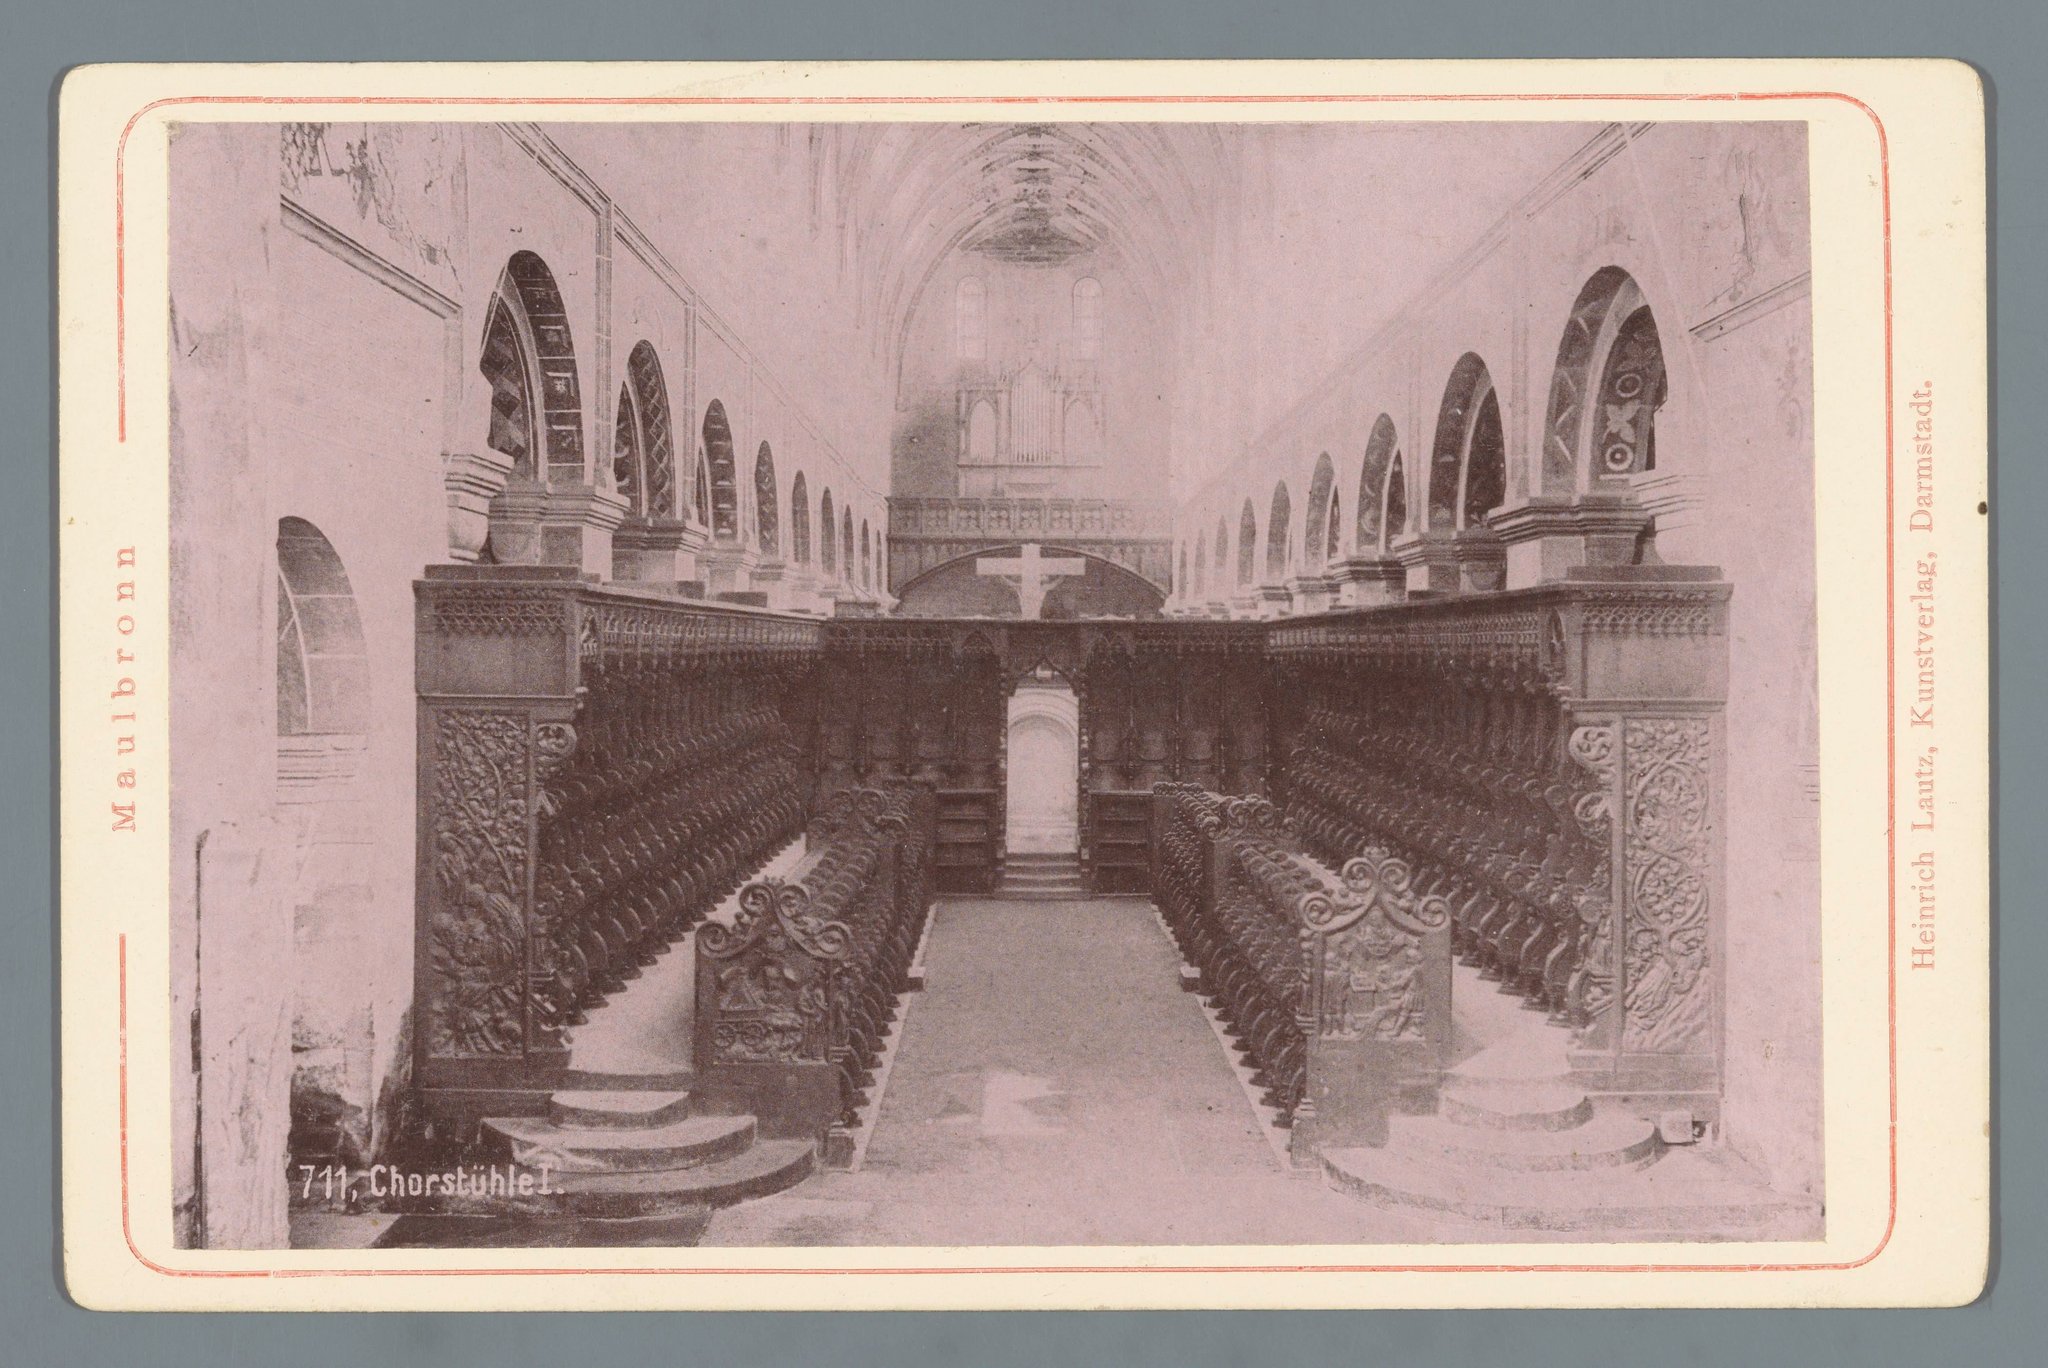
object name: photomechanical print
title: Koorstoelen in de Abdij van Maulbronn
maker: Anonymous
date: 1895-1900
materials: cardboard, paper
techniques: photograph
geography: maulbronn abbey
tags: abbey, monastery, convent ~ roman catholic church, interior ~ representation of a building, seats of the clergy, choir-stalls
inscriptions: number: ‘711’, inscription: ‘17 Juli 1894.’